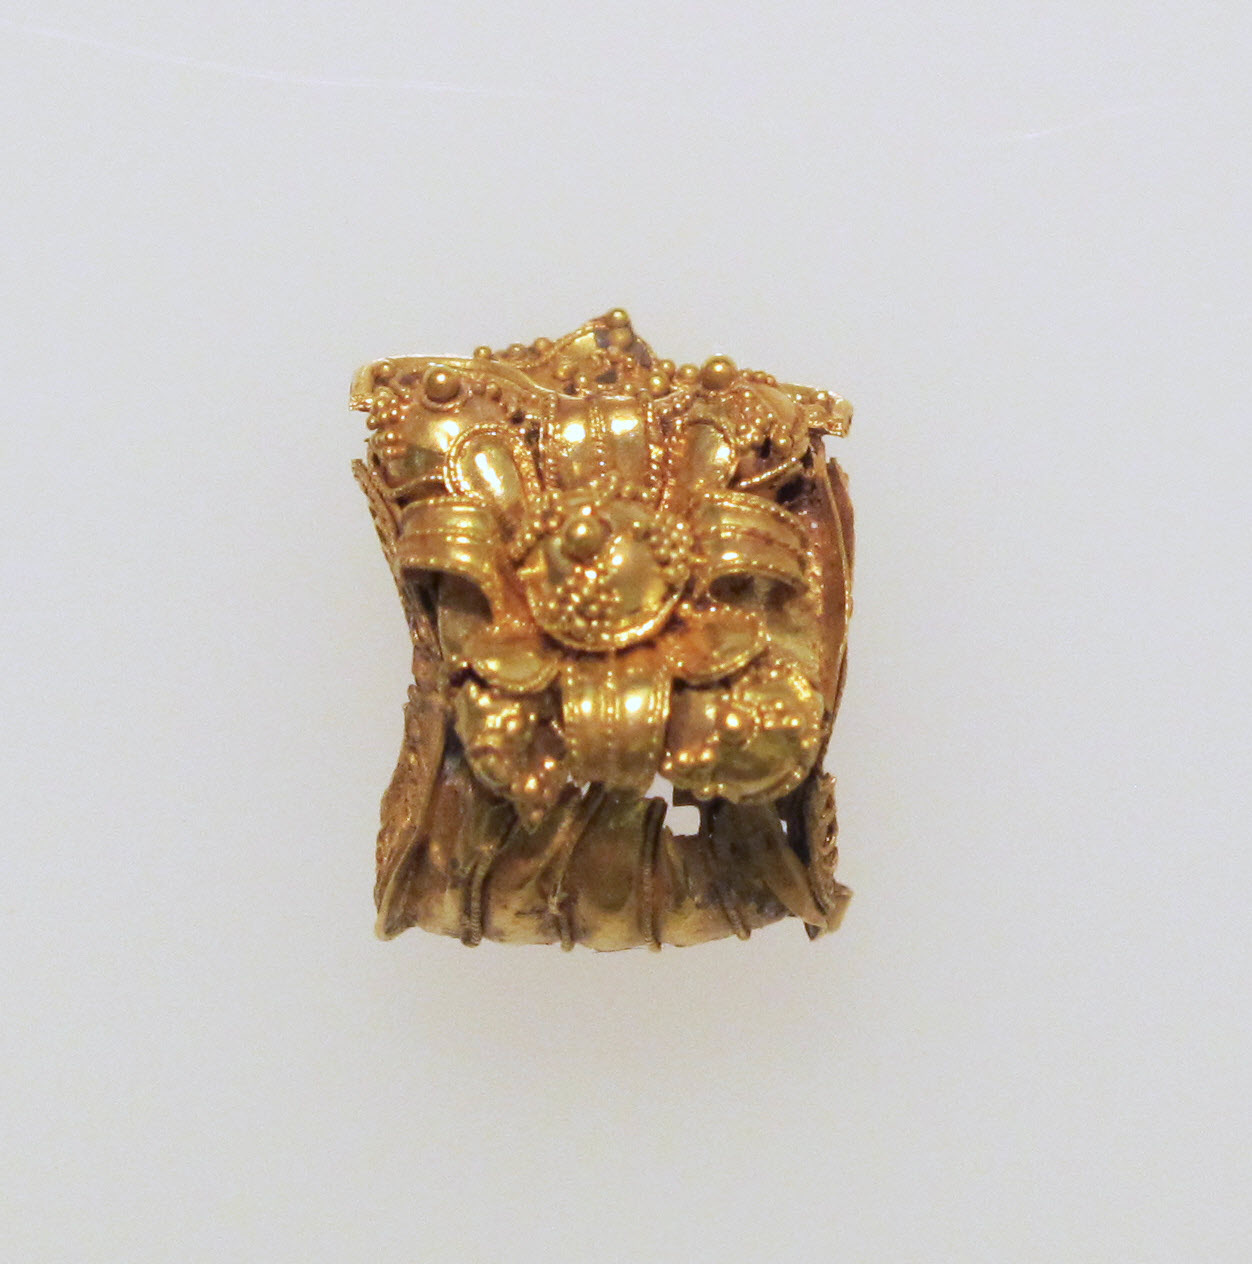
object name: earring, baule type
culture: etruscan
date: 700-401 BCE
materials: gold